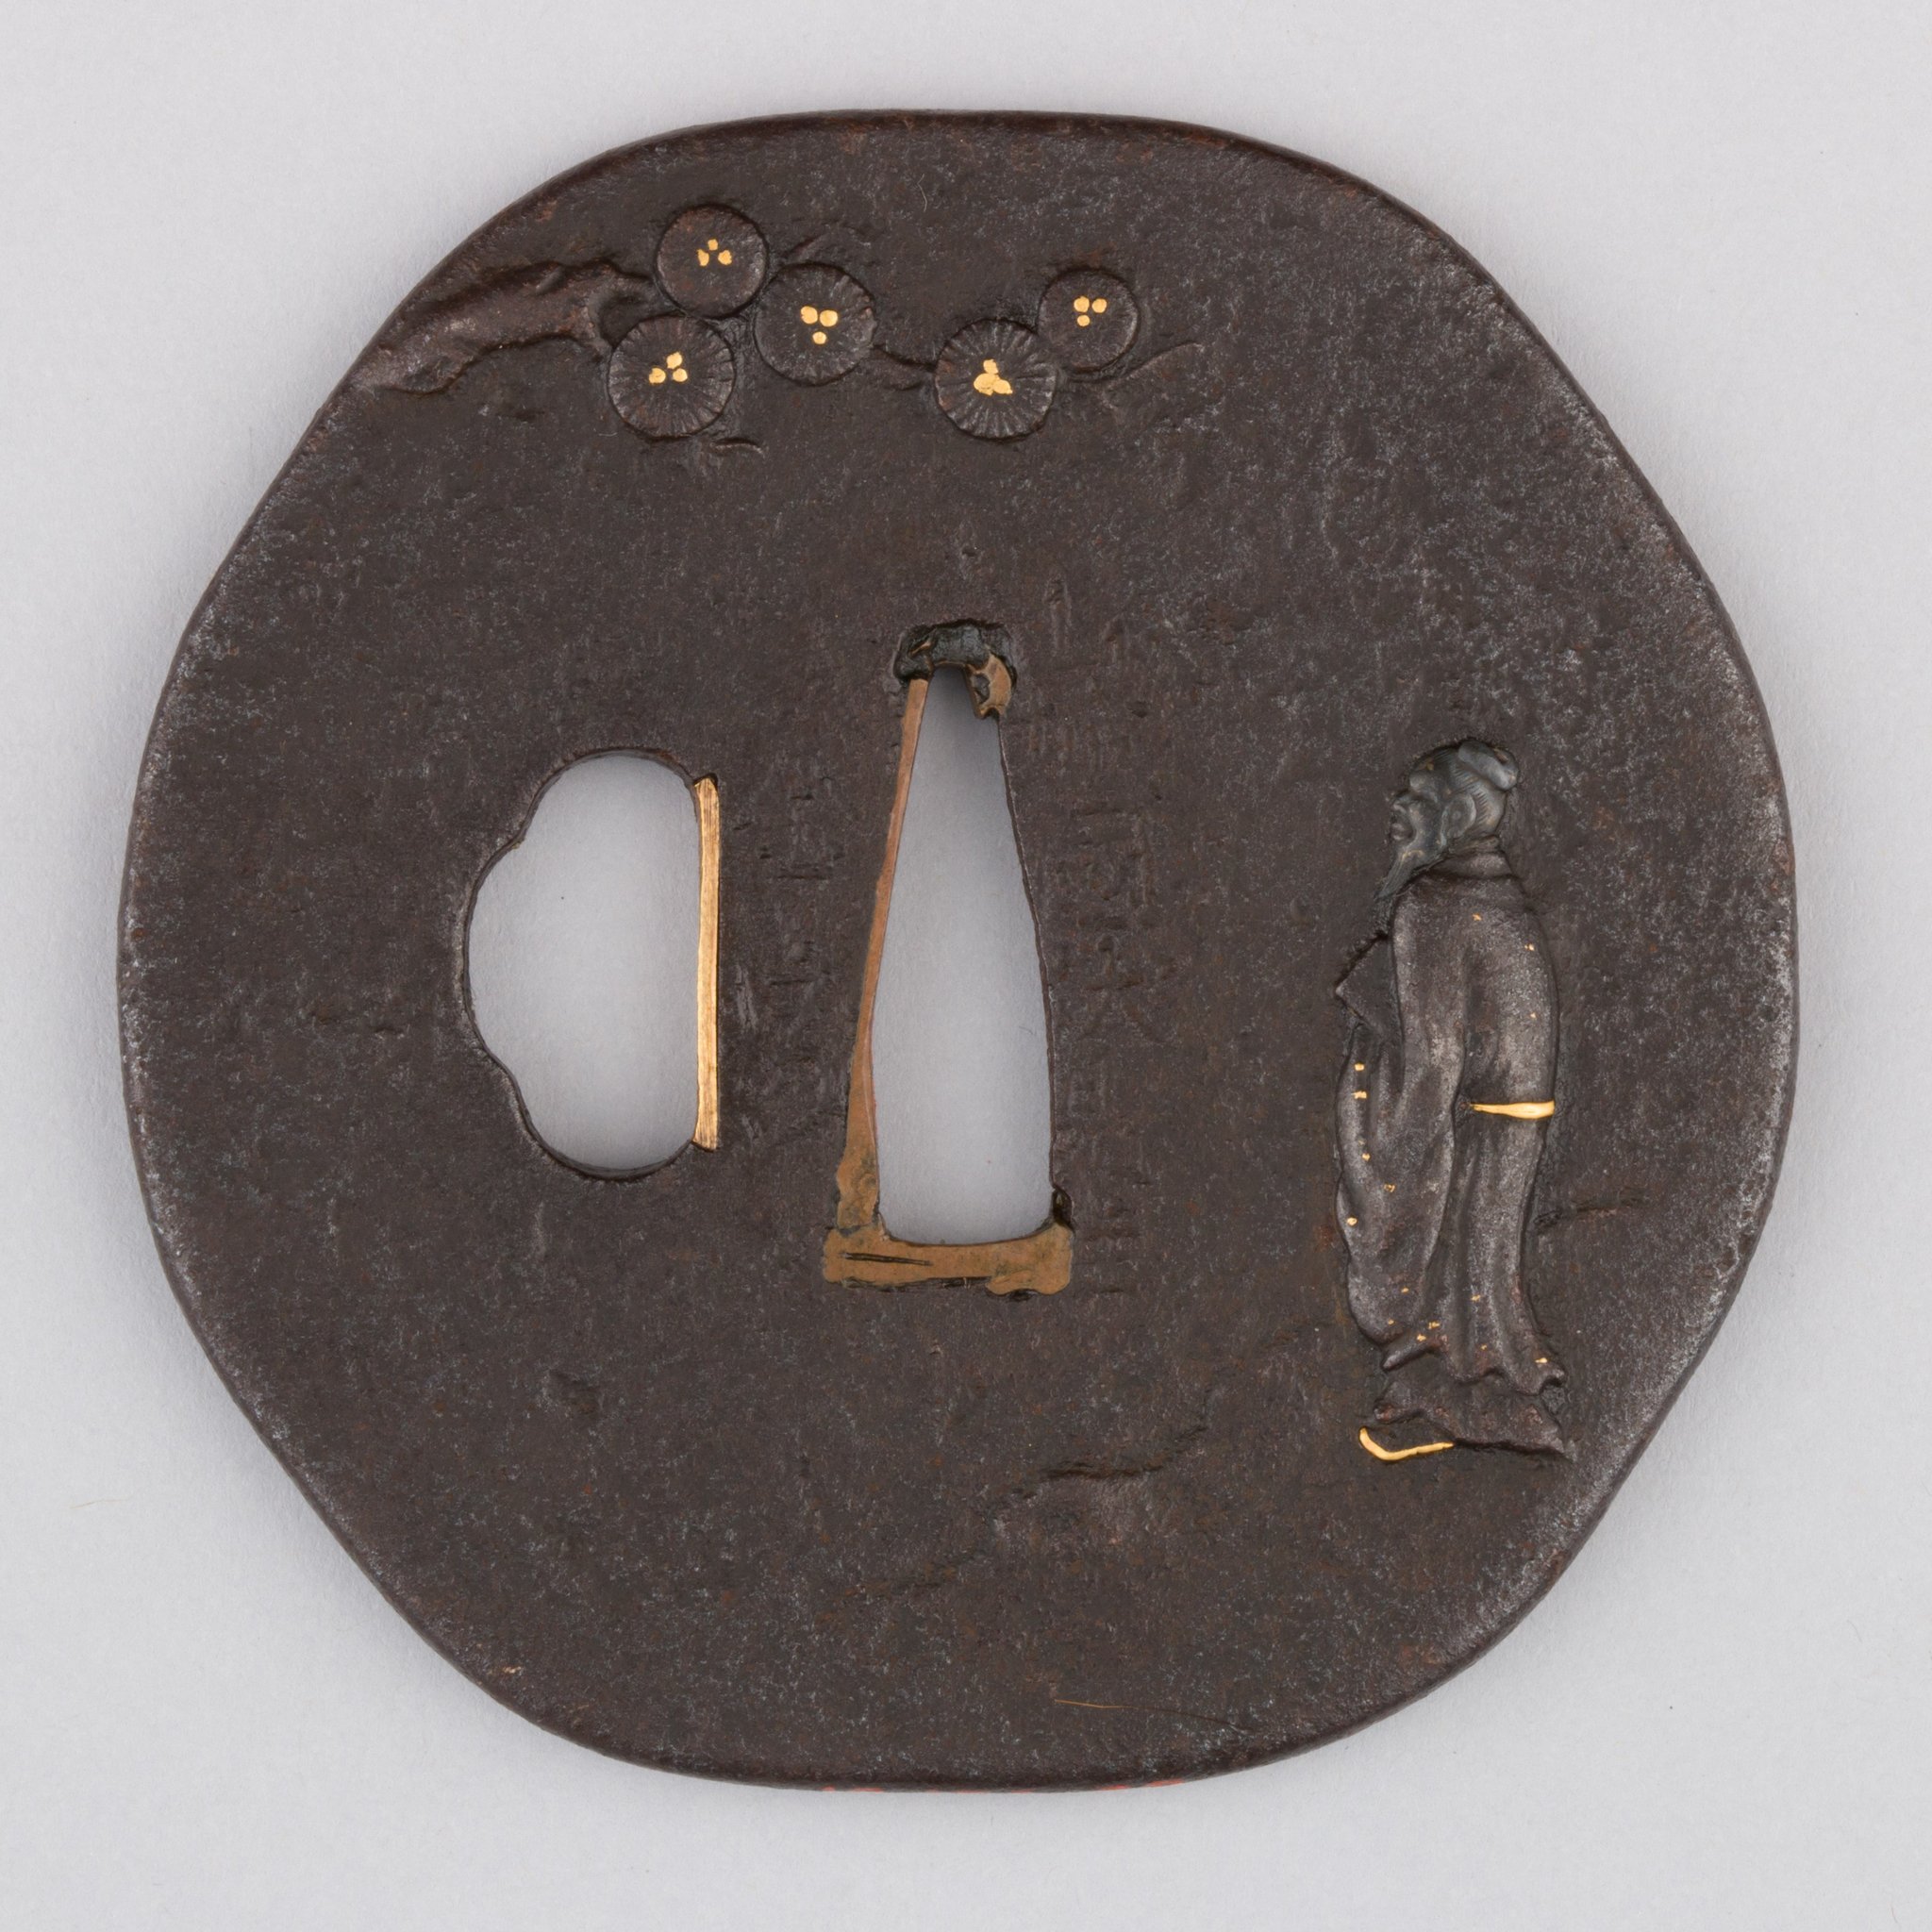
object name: sword guard tsuba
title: Sword Guard (Tsuba)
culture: japanese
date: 1615-1868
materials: copper, iron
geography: japan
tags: men